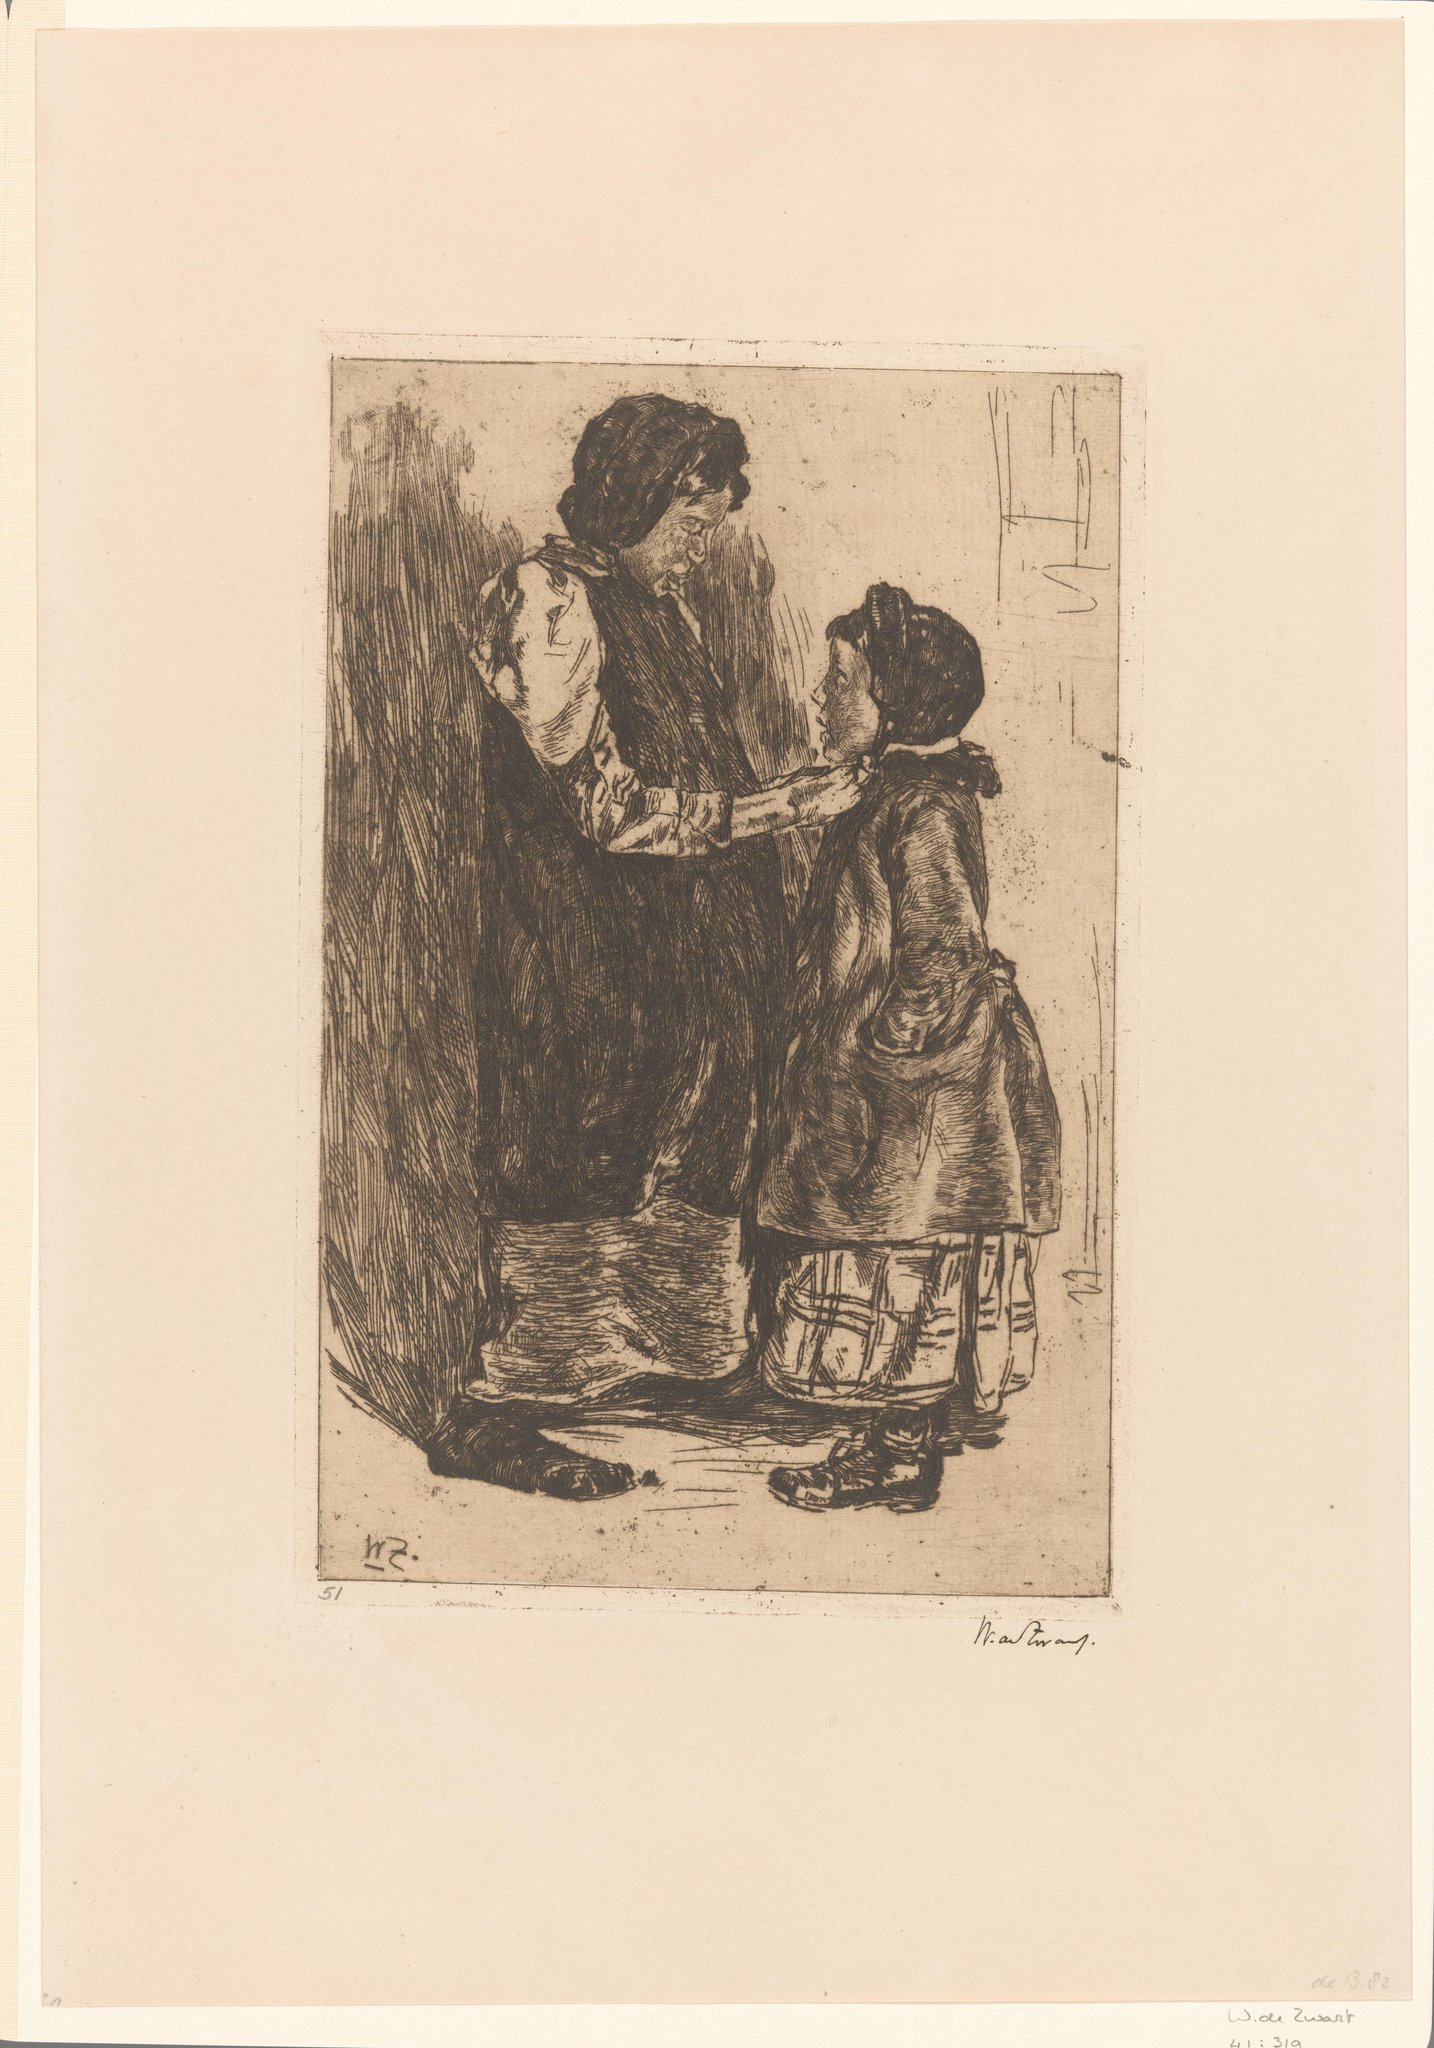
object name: print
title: Twee meisjes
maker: willem de zwart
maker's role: draughtsman, painter, print maker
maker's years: 1862-1931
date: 1896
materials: paper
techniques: drypoint, etching, intaglio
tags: dressing someone else - aa - female human figure, girl (child between toddler and youth)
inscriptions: collector's mark: Lugt 2228, collector's mark: Lugt 2760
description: Het grote meisjes helpt het kleine meisje met aankleden.